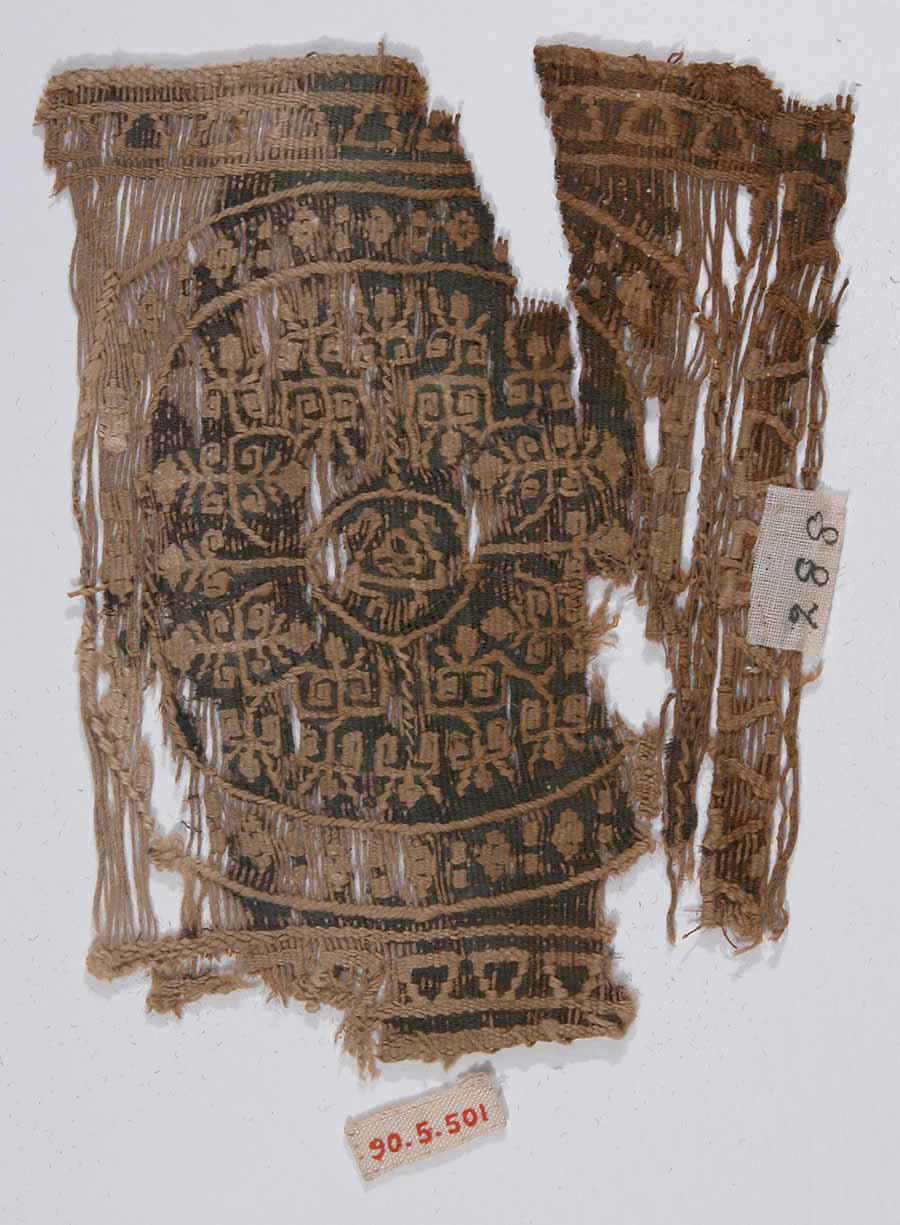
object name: textile fragment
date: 301-500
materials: linen, wool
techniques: weave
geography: egypt